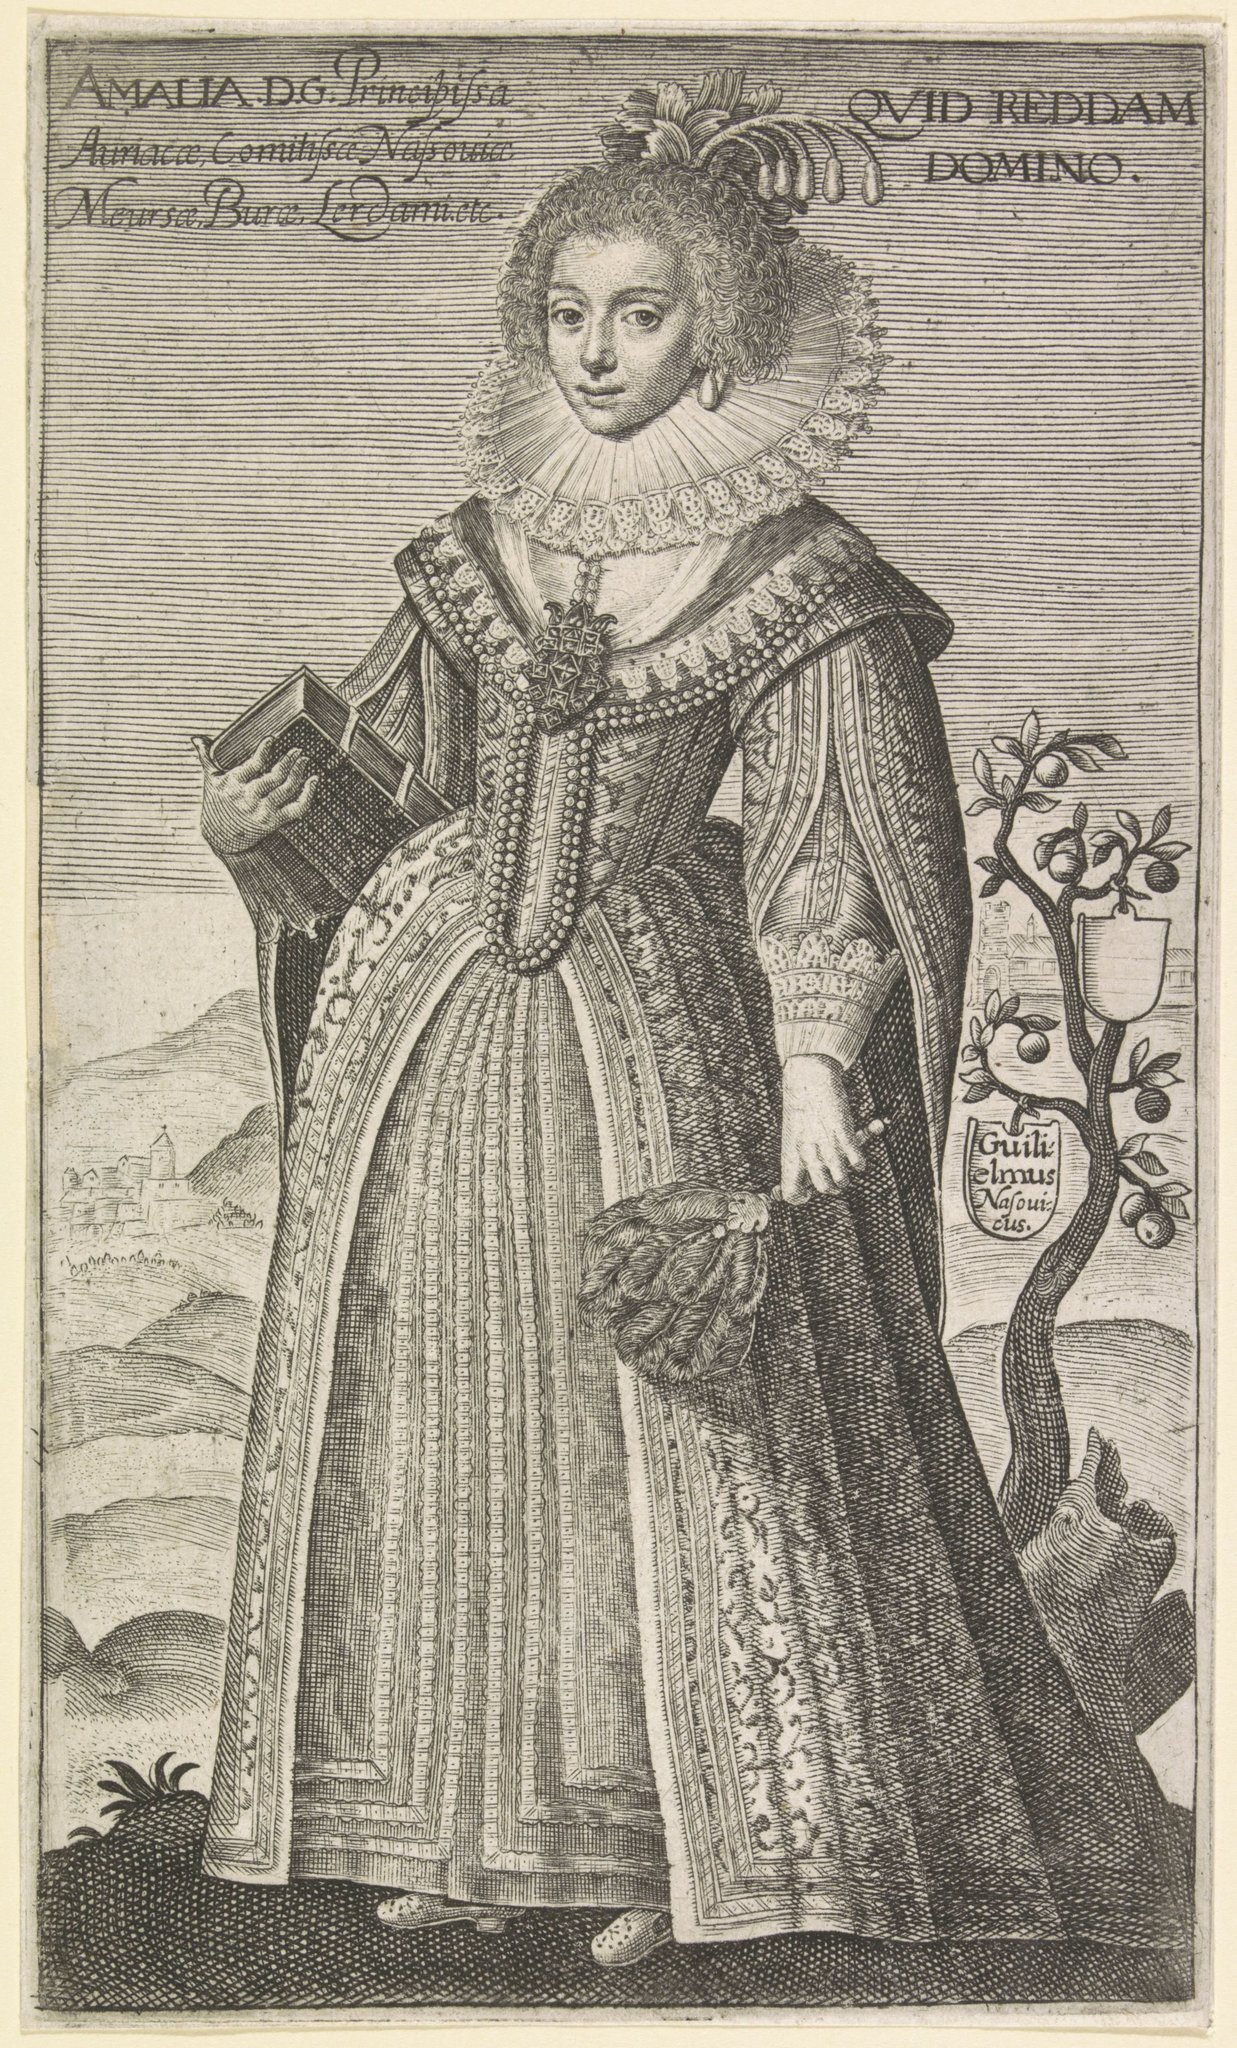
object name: print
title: Portret van Amalia van Solms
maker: crispijn van de passe (i)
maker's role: draughtsman, print maker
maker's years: 1564-1637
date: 1620-1637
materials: paper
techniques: engraving, etching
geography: low countries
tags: amalia of solms-braunfels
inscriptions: collector's mark: Lugt 963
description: Portret van Amalia. Ze staat in een landschap met in haar linkerhand een waaier en in haar rechterhand een kerkboek. Linksboven haar naam en rechtsboven haar lijfspreuk.